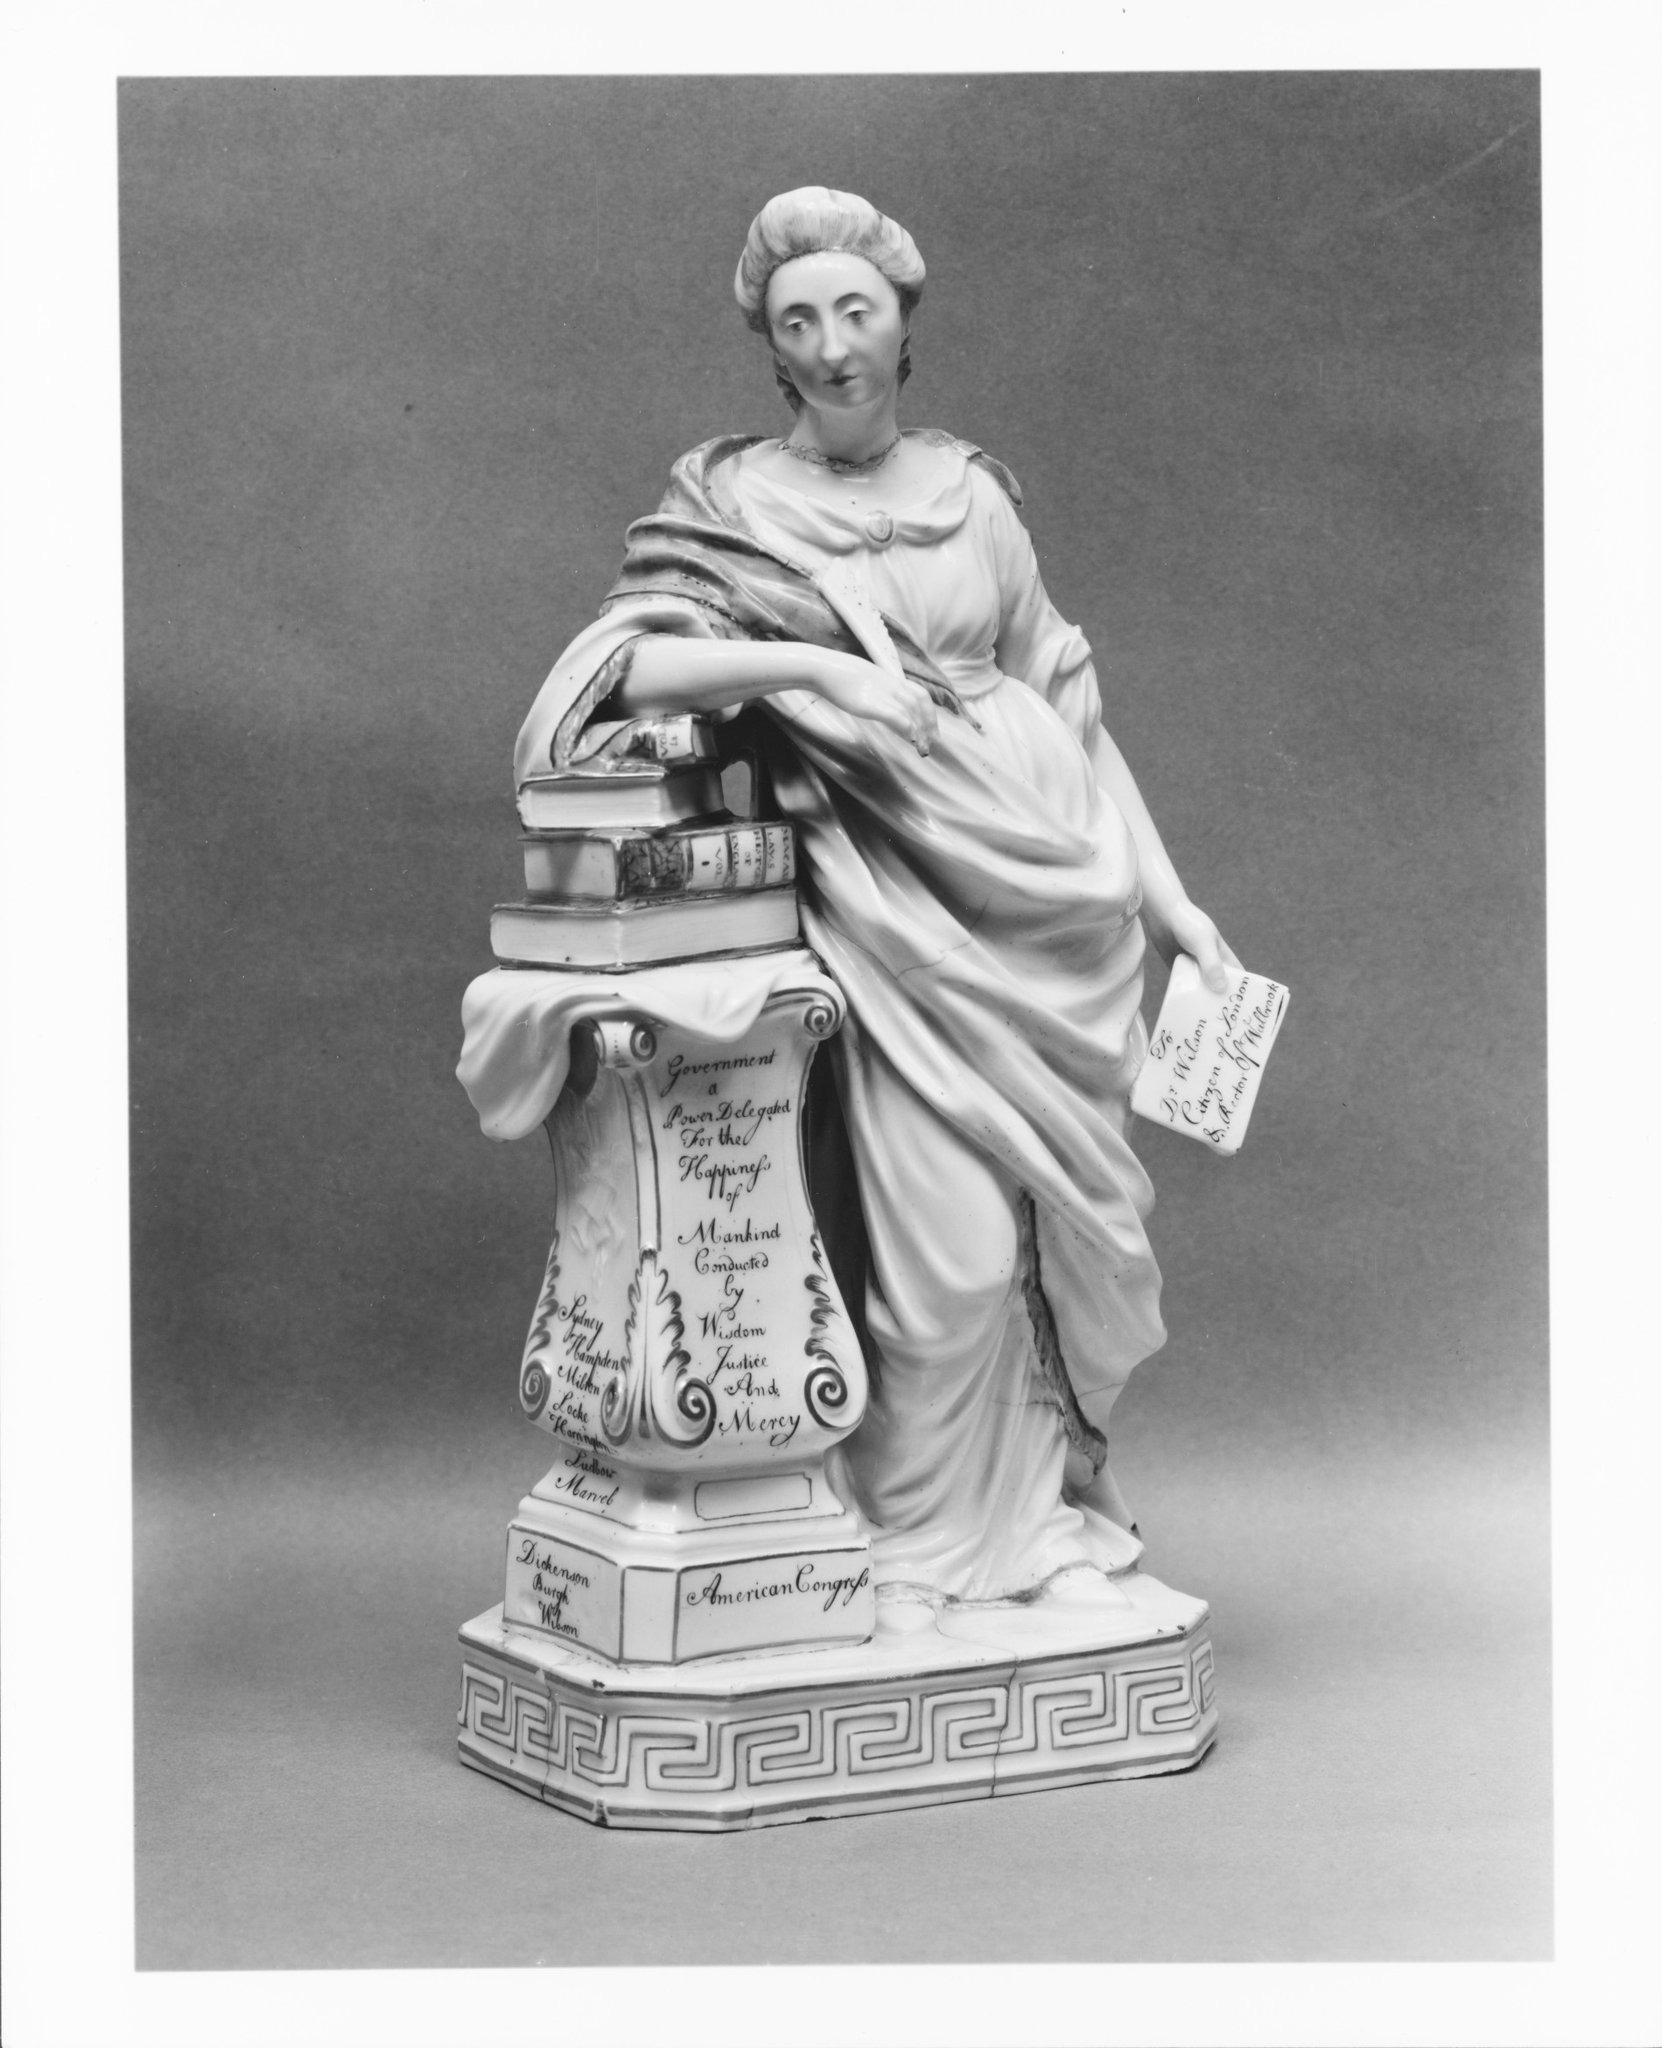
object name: figure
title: Figure of Mrs. Catherine Macaulay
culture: british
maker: chelsea factory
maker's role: maker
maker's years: 1742-1784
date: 1775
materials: porcelain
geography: england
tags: books,portraits,women